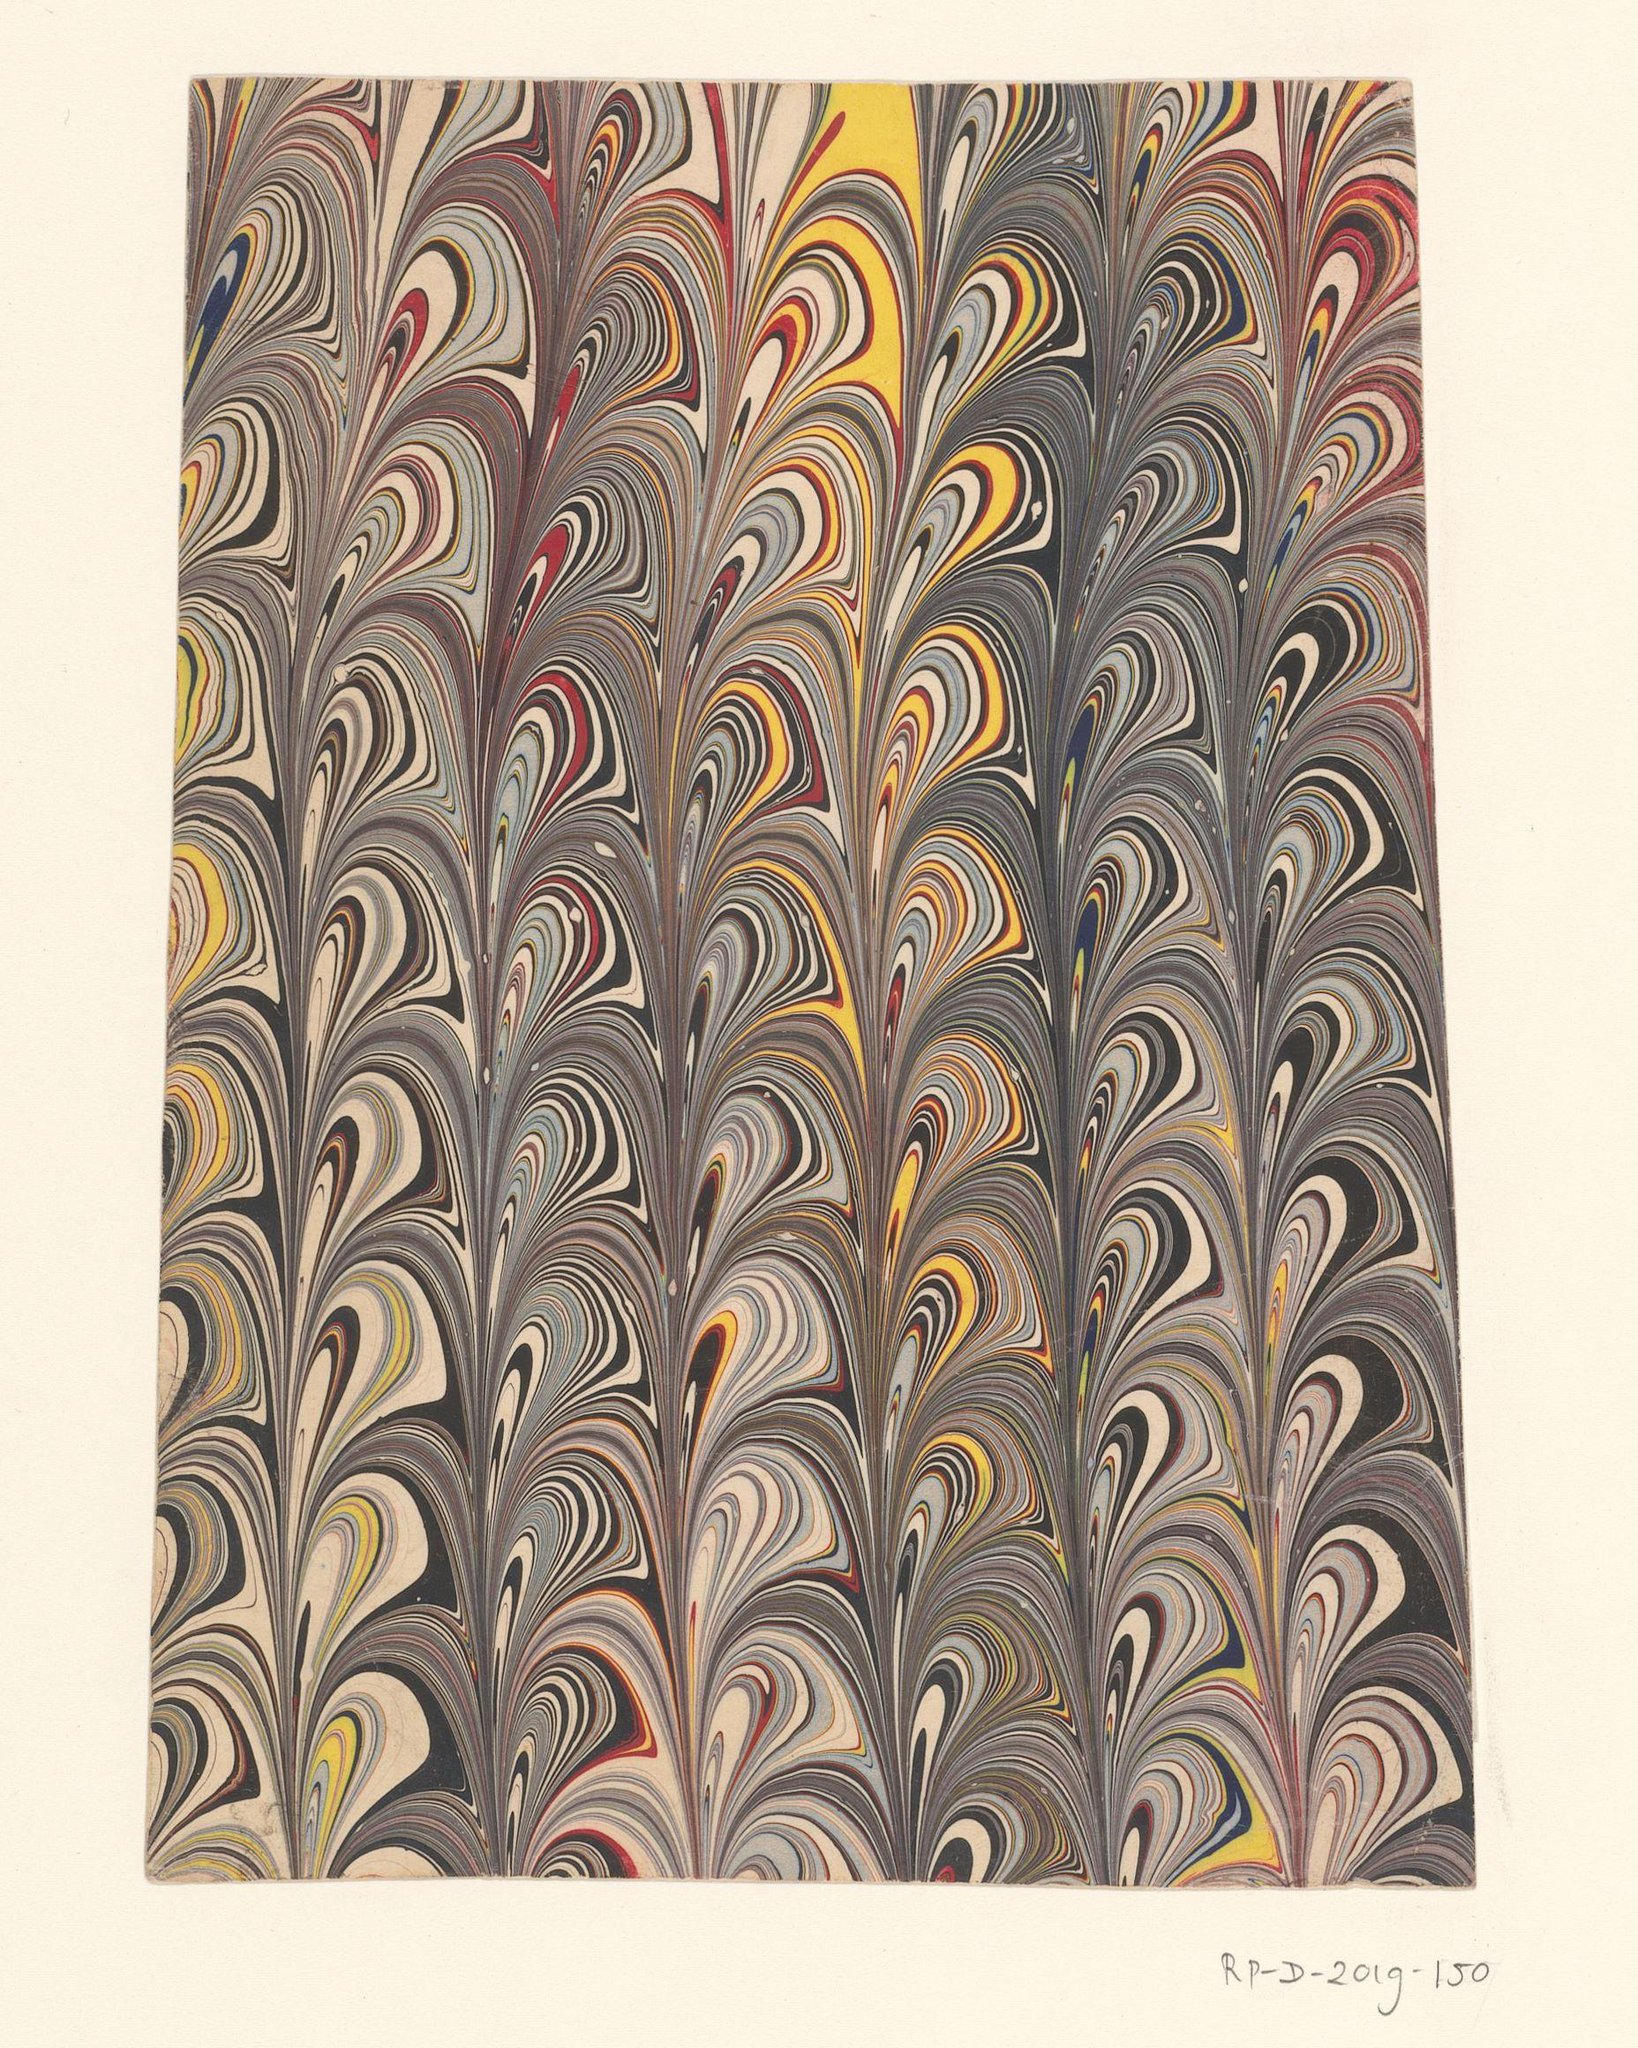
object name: marbled paper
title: Pauwenstaartmarmer in meerdere kleuren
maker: Anonymous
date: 1850-1950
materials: paint, paper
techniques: marbling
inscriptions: collector's mark: Lugt 2228